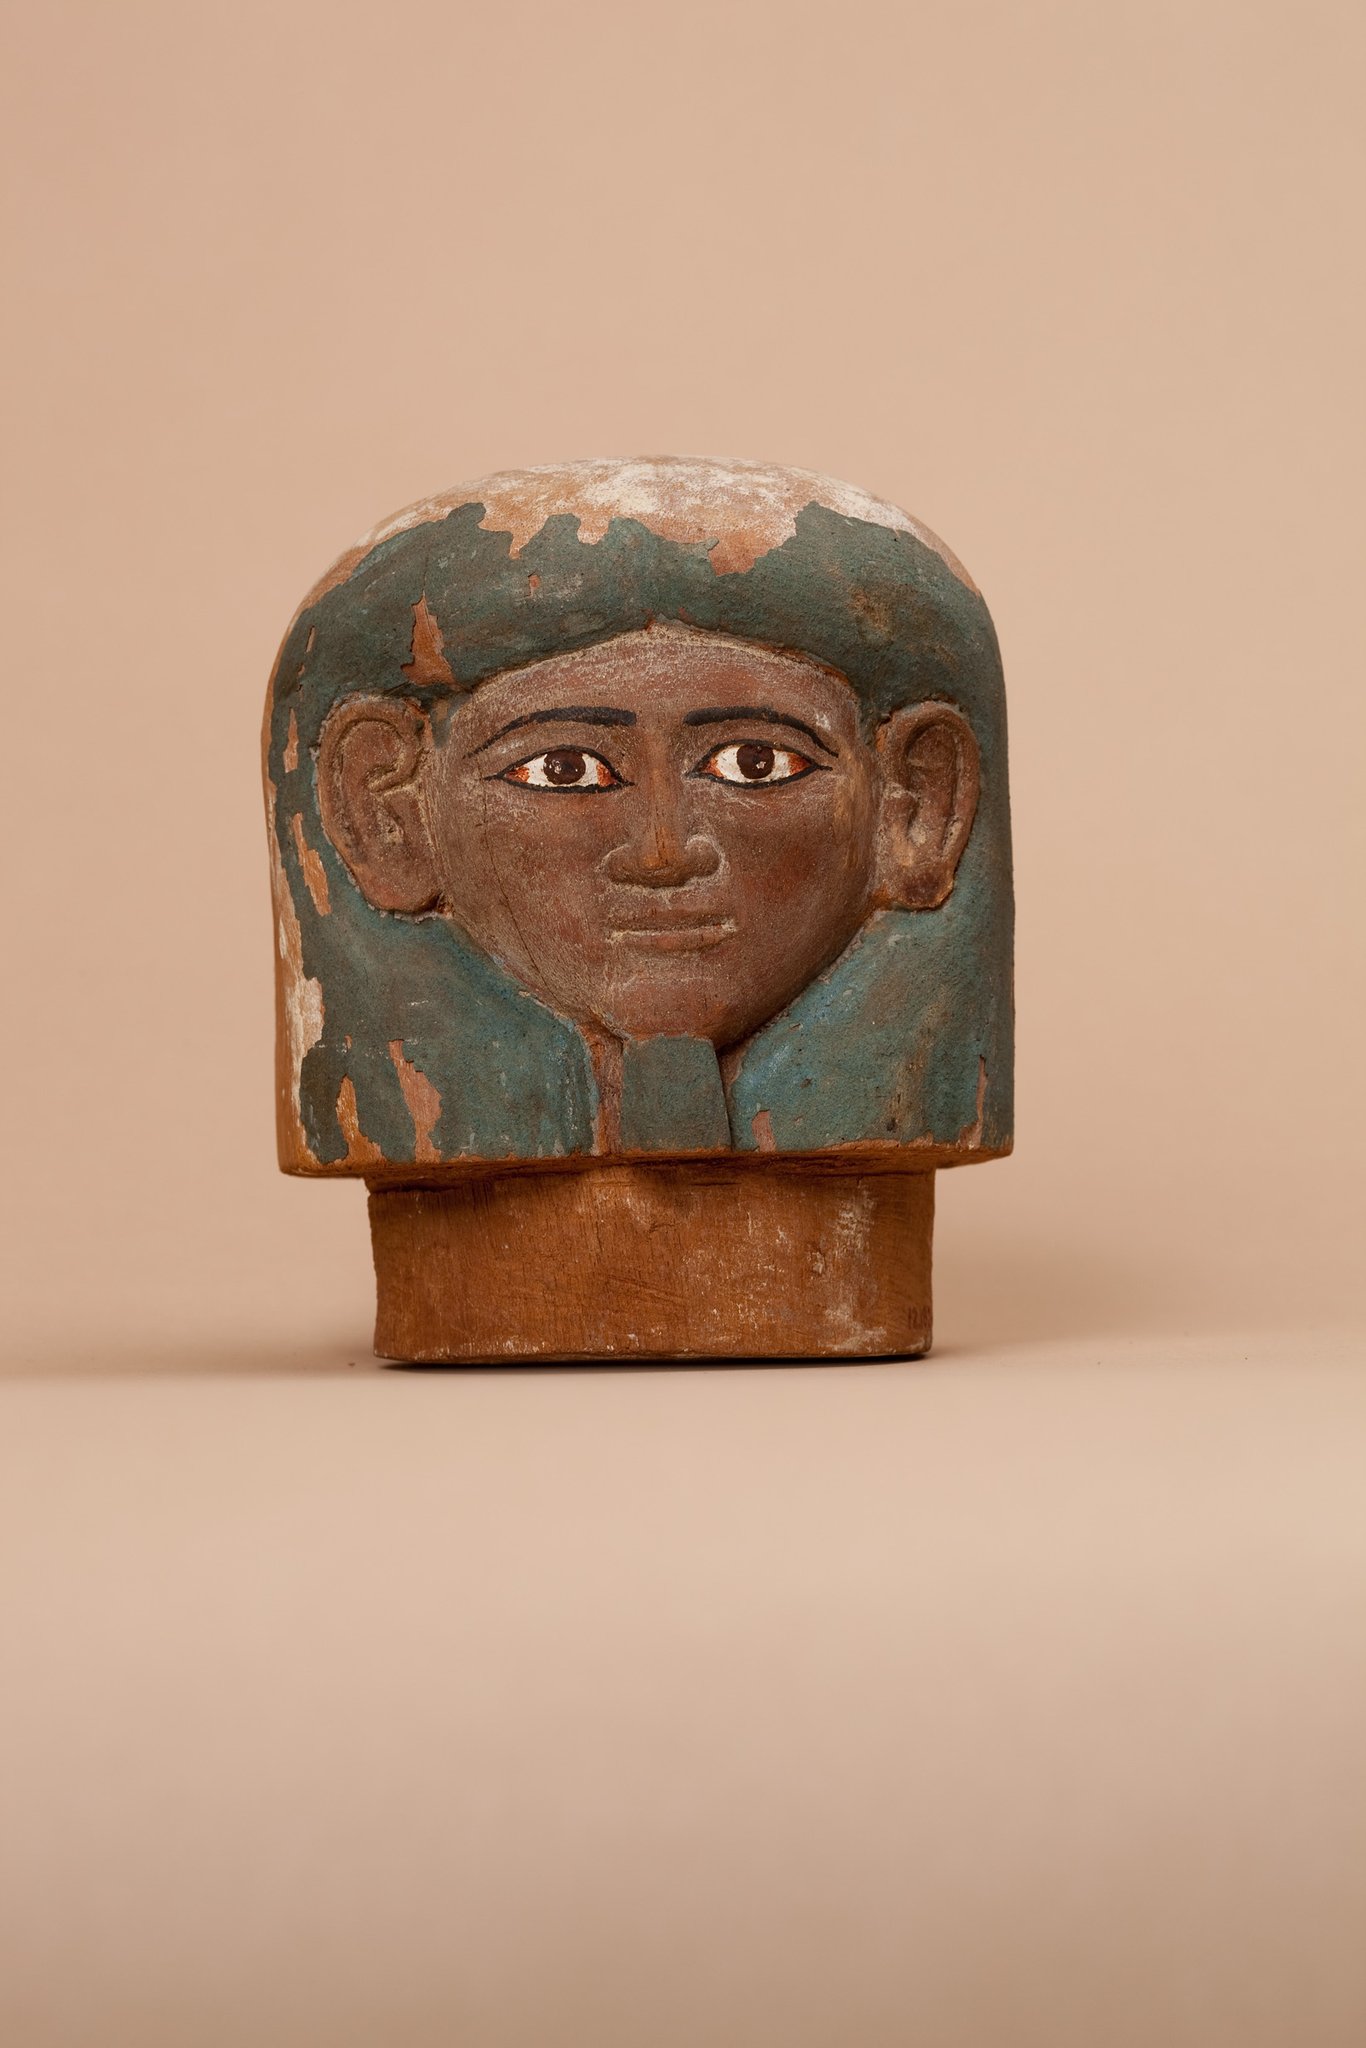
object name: canopic jar lid, ukhhotep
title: Canopic jar lid of Ukhhotep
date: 1981-1802 BCE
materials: paint, wood